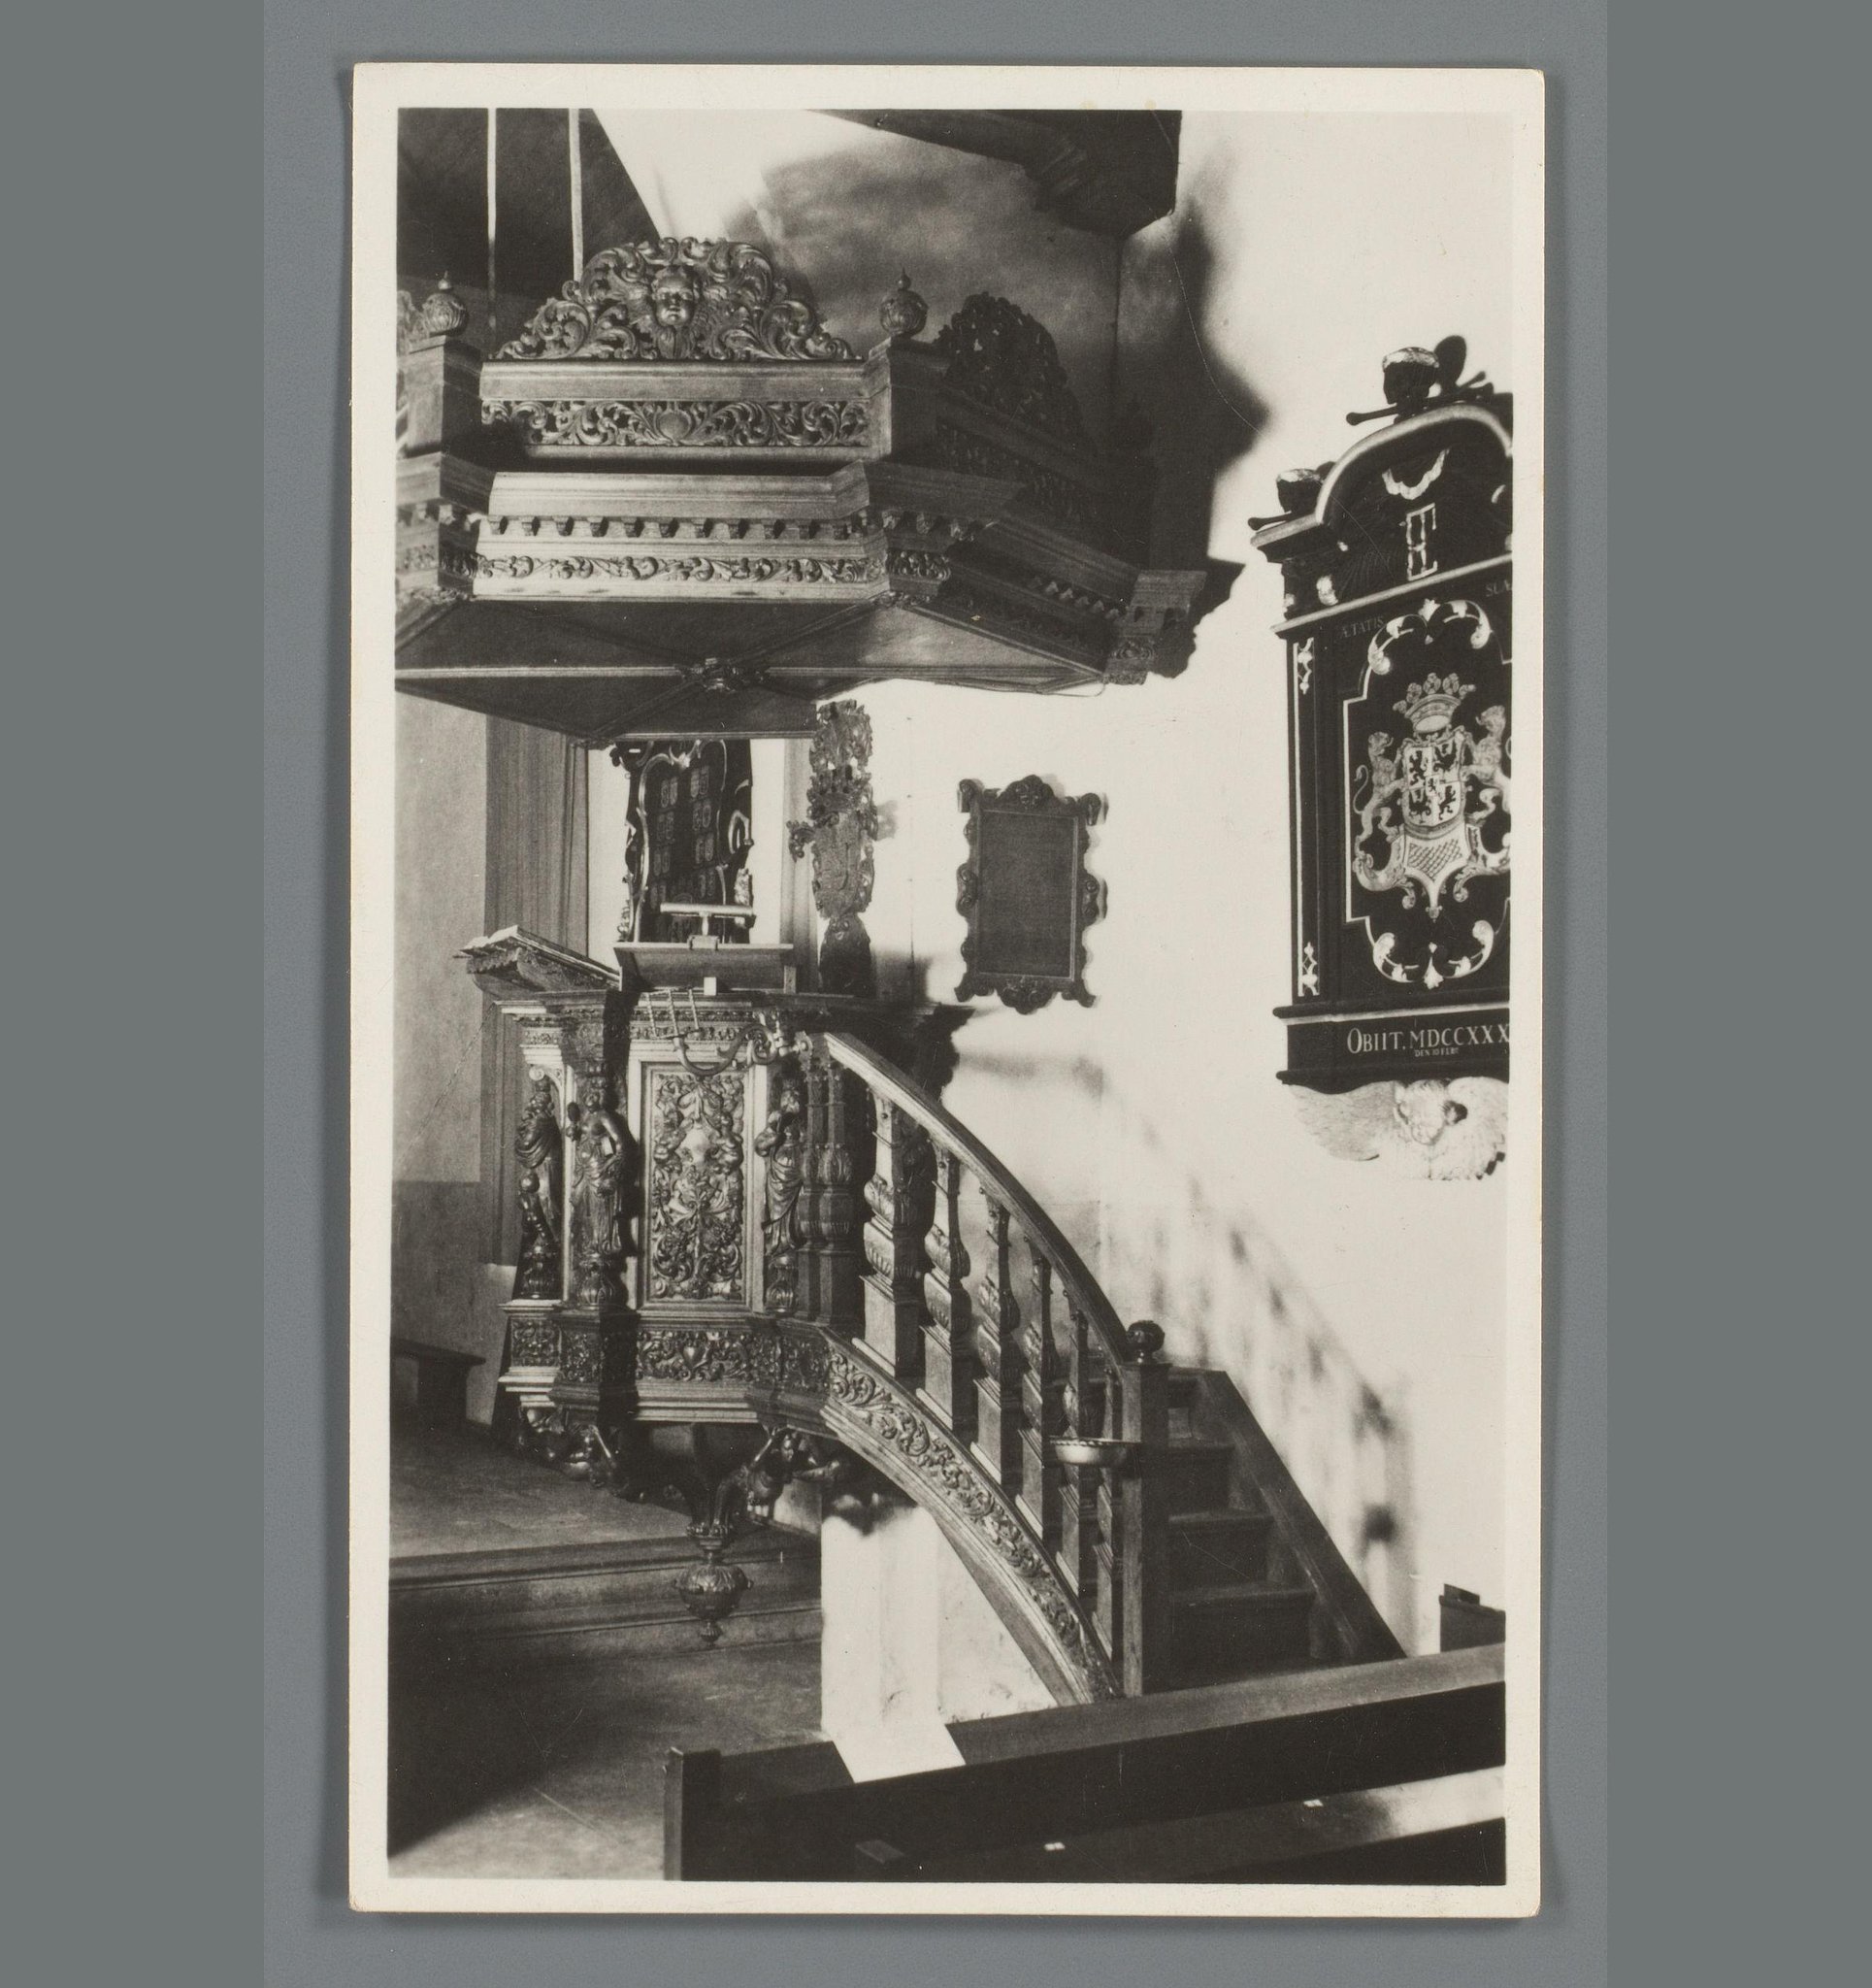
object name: photograph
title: Midwolde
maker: Anonymous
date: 1950-1970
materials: paper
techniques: gelatin silver print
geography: netherlands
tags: interior of church, pulpit, ambo, chancel